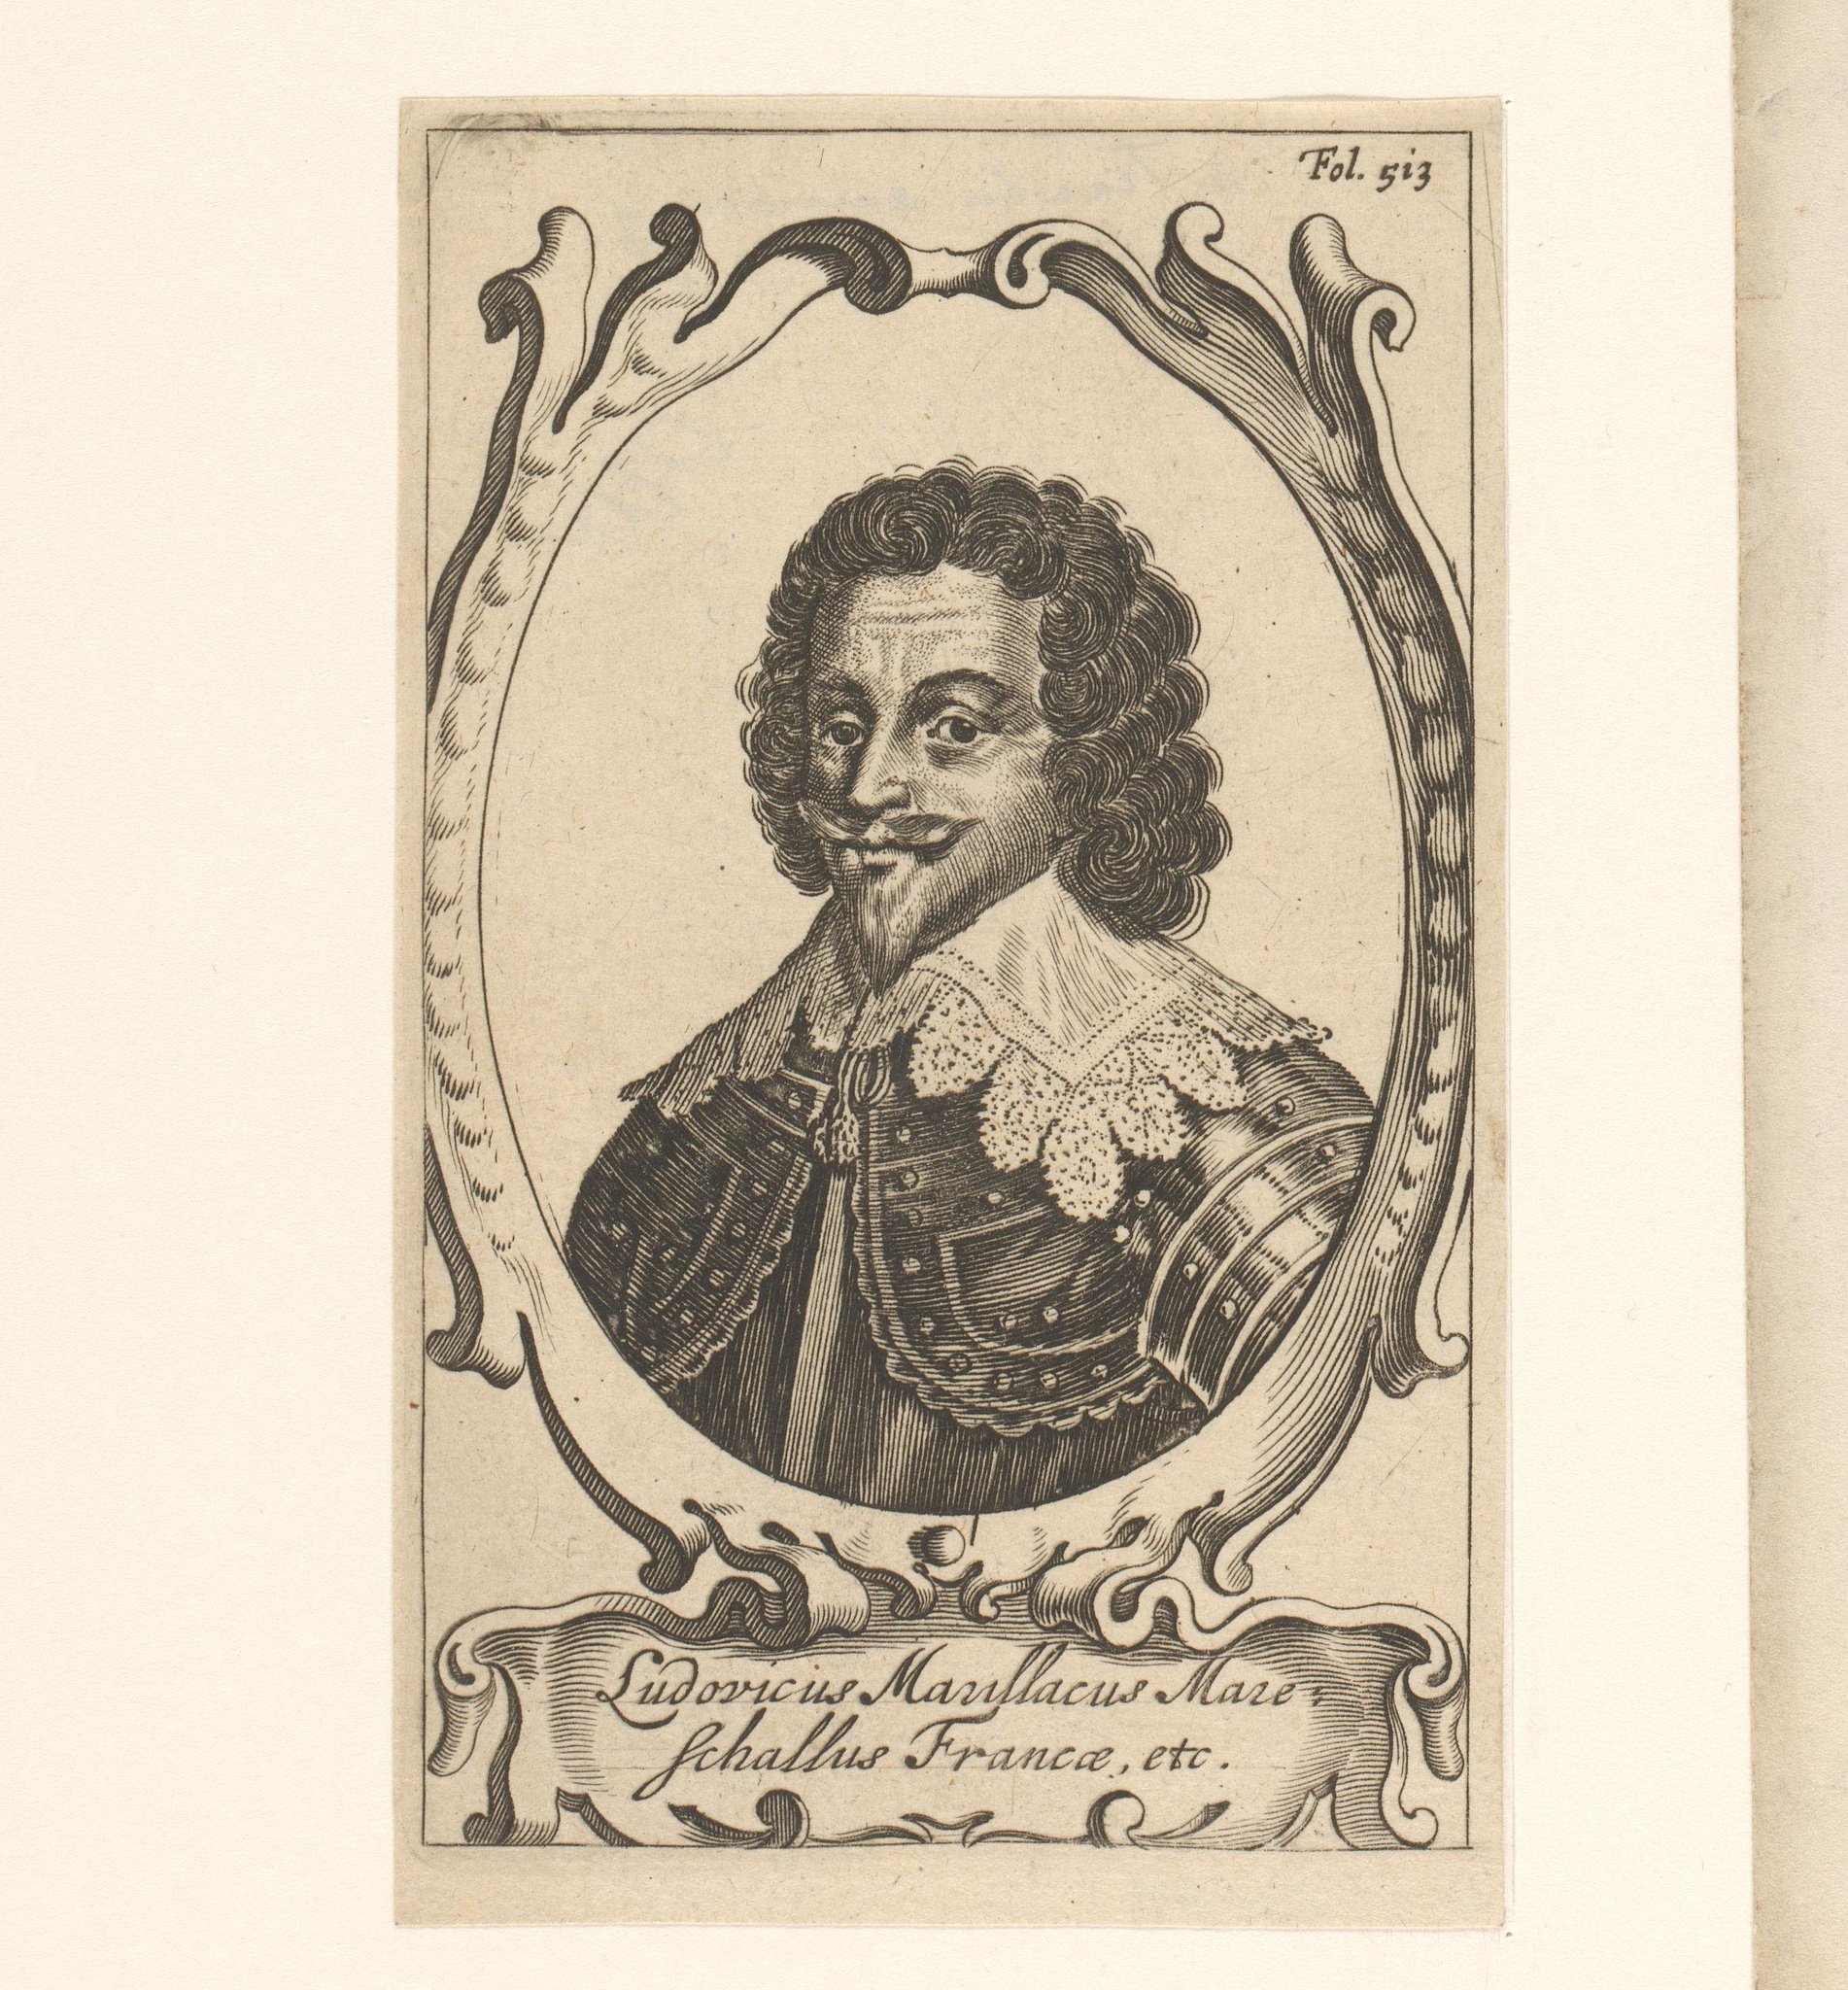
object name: print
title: Portret van Louis de Marillac, graaf van Beaumont-le-Roger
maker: Anonymous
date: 1629-1699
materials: paper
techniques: engraving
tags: paris, earl, commander-in-chief, general, marshal, historical persons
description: In een ovaal met onder het portret zijn naam en titel. Rechtsboven genummerd: fol. 513.